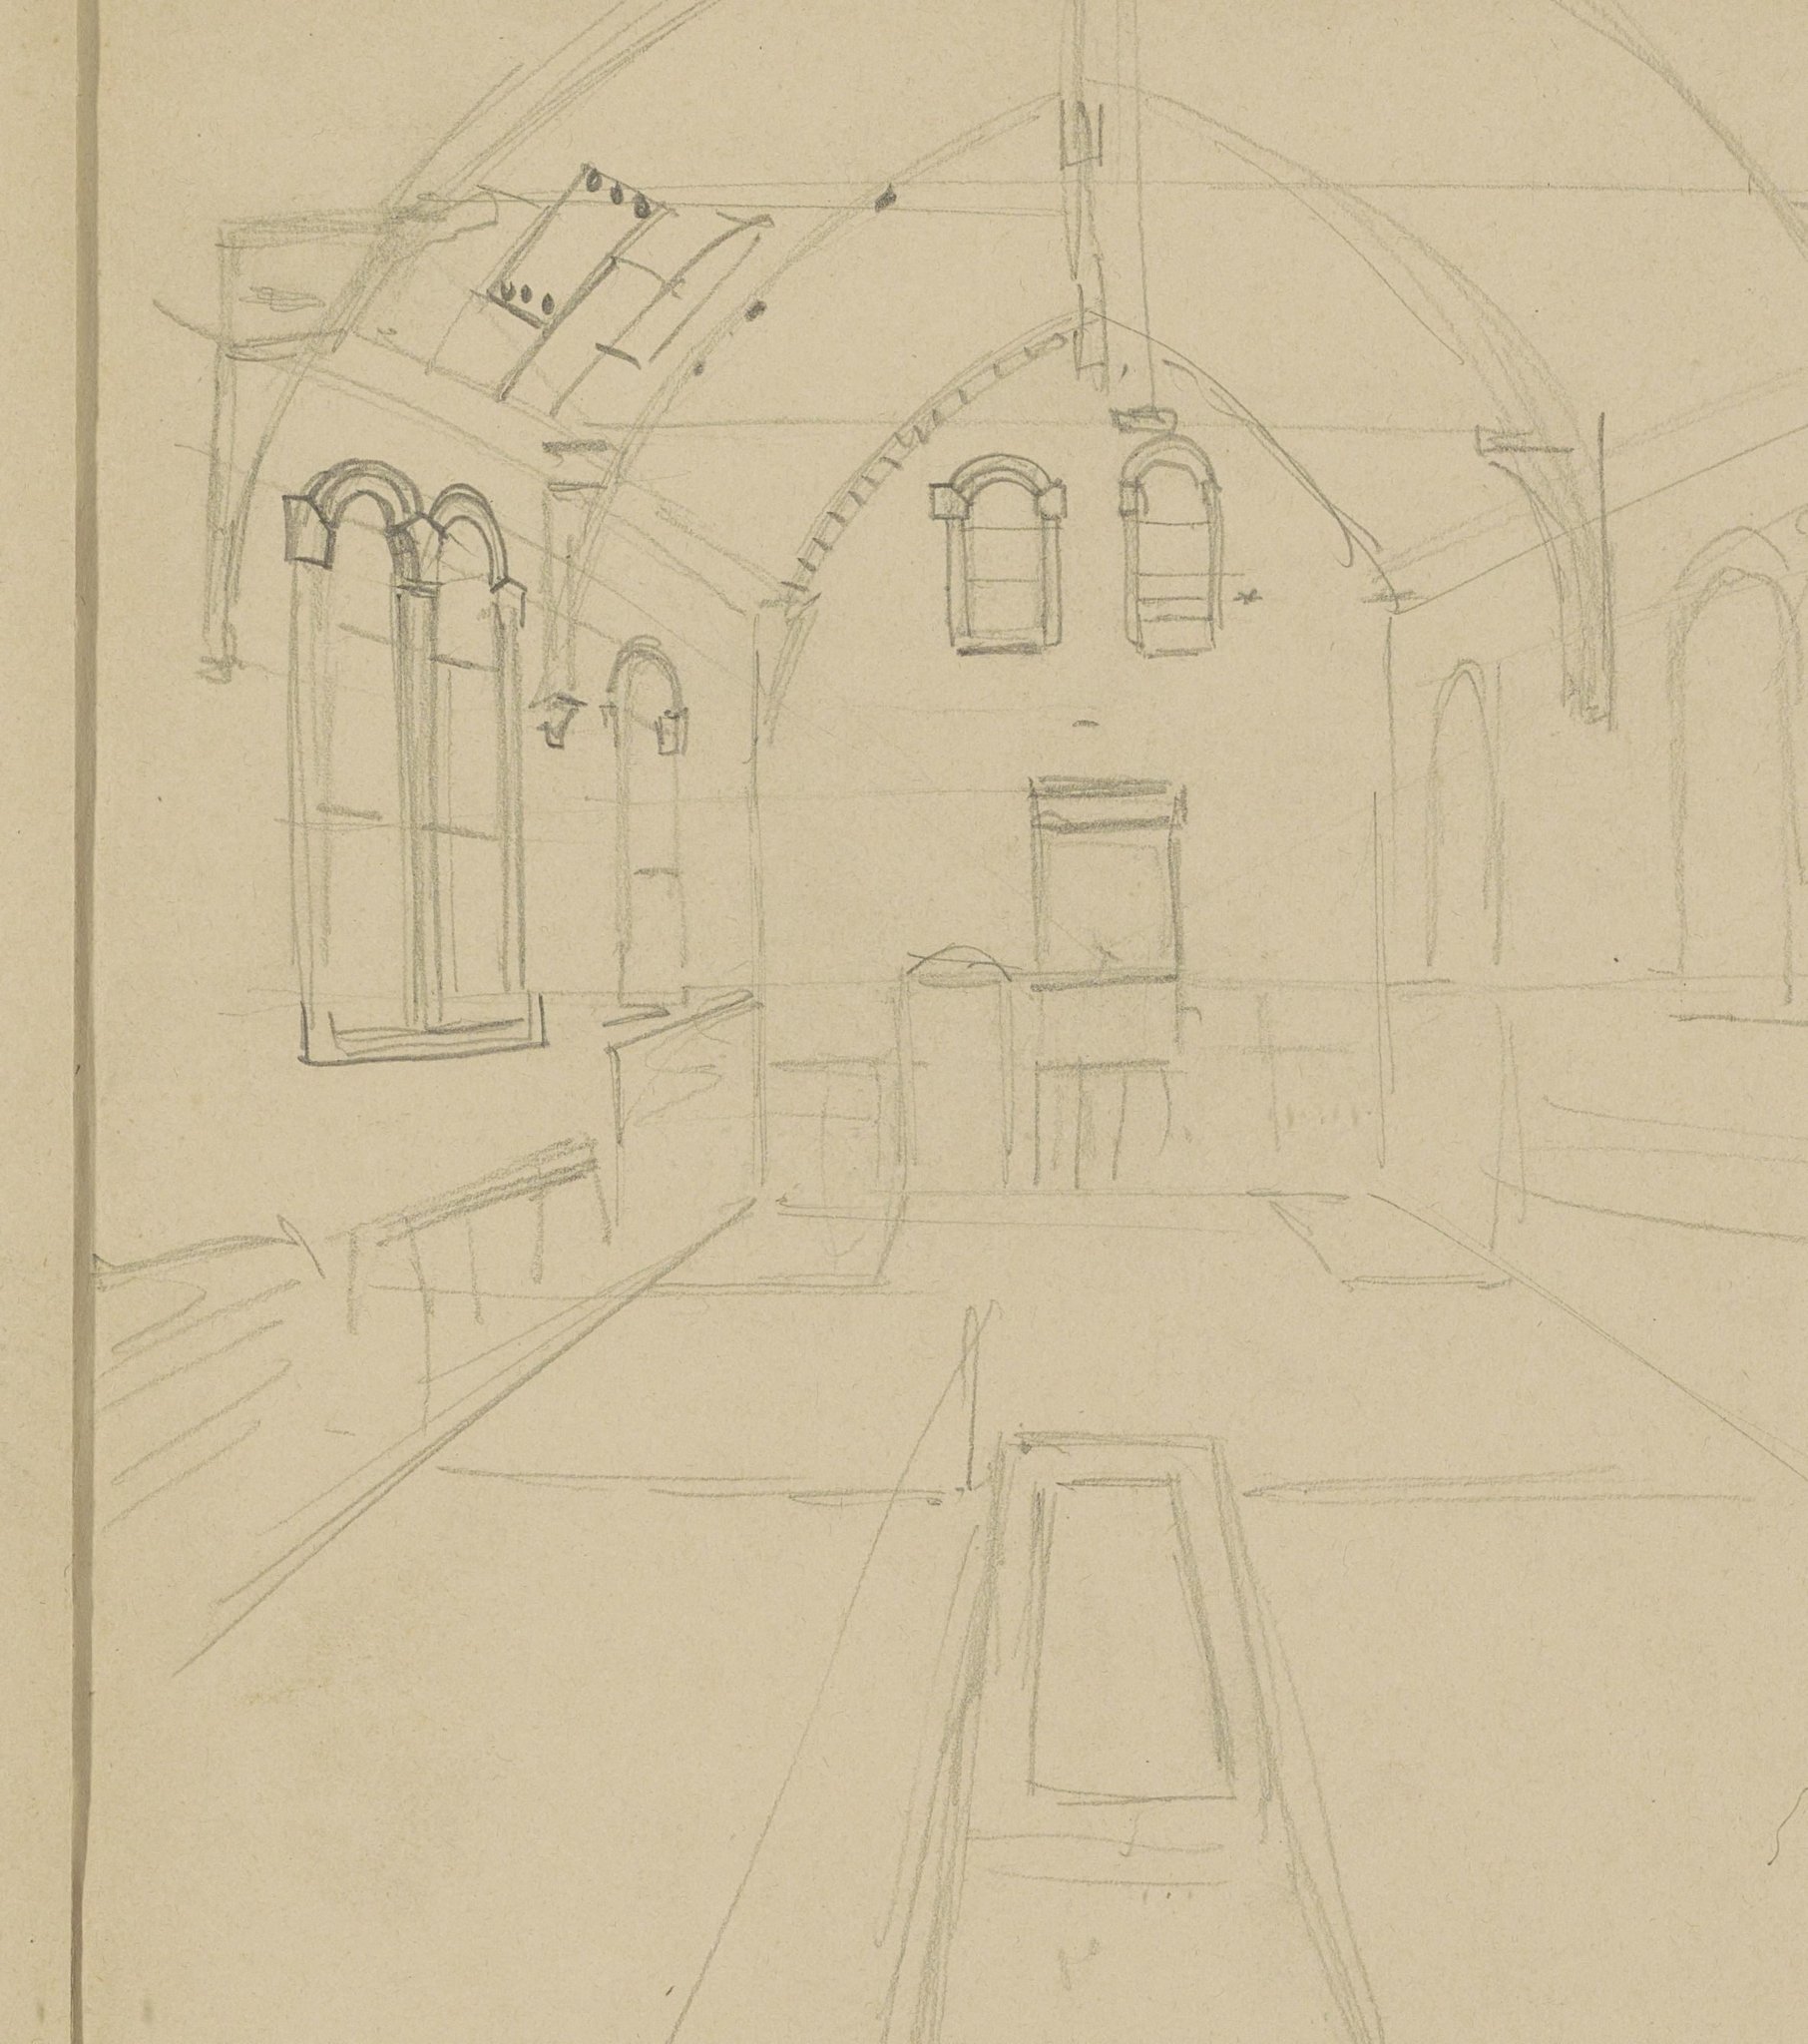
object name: sketchbook leaf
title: Ontwerp voor het interieur van de gereformeerde kerk te Vreeland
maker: carel adolph lion cachet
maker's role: draughtsman, print maker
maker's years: 1864-1945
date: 1905-1906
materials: paper, pencil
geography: vreeland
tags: interior of church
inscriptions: annotation: ‘19 cm dagmaa[...]/ 5 ramen’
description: Blad 17 recto uit een schetsboek met 30 bladen.